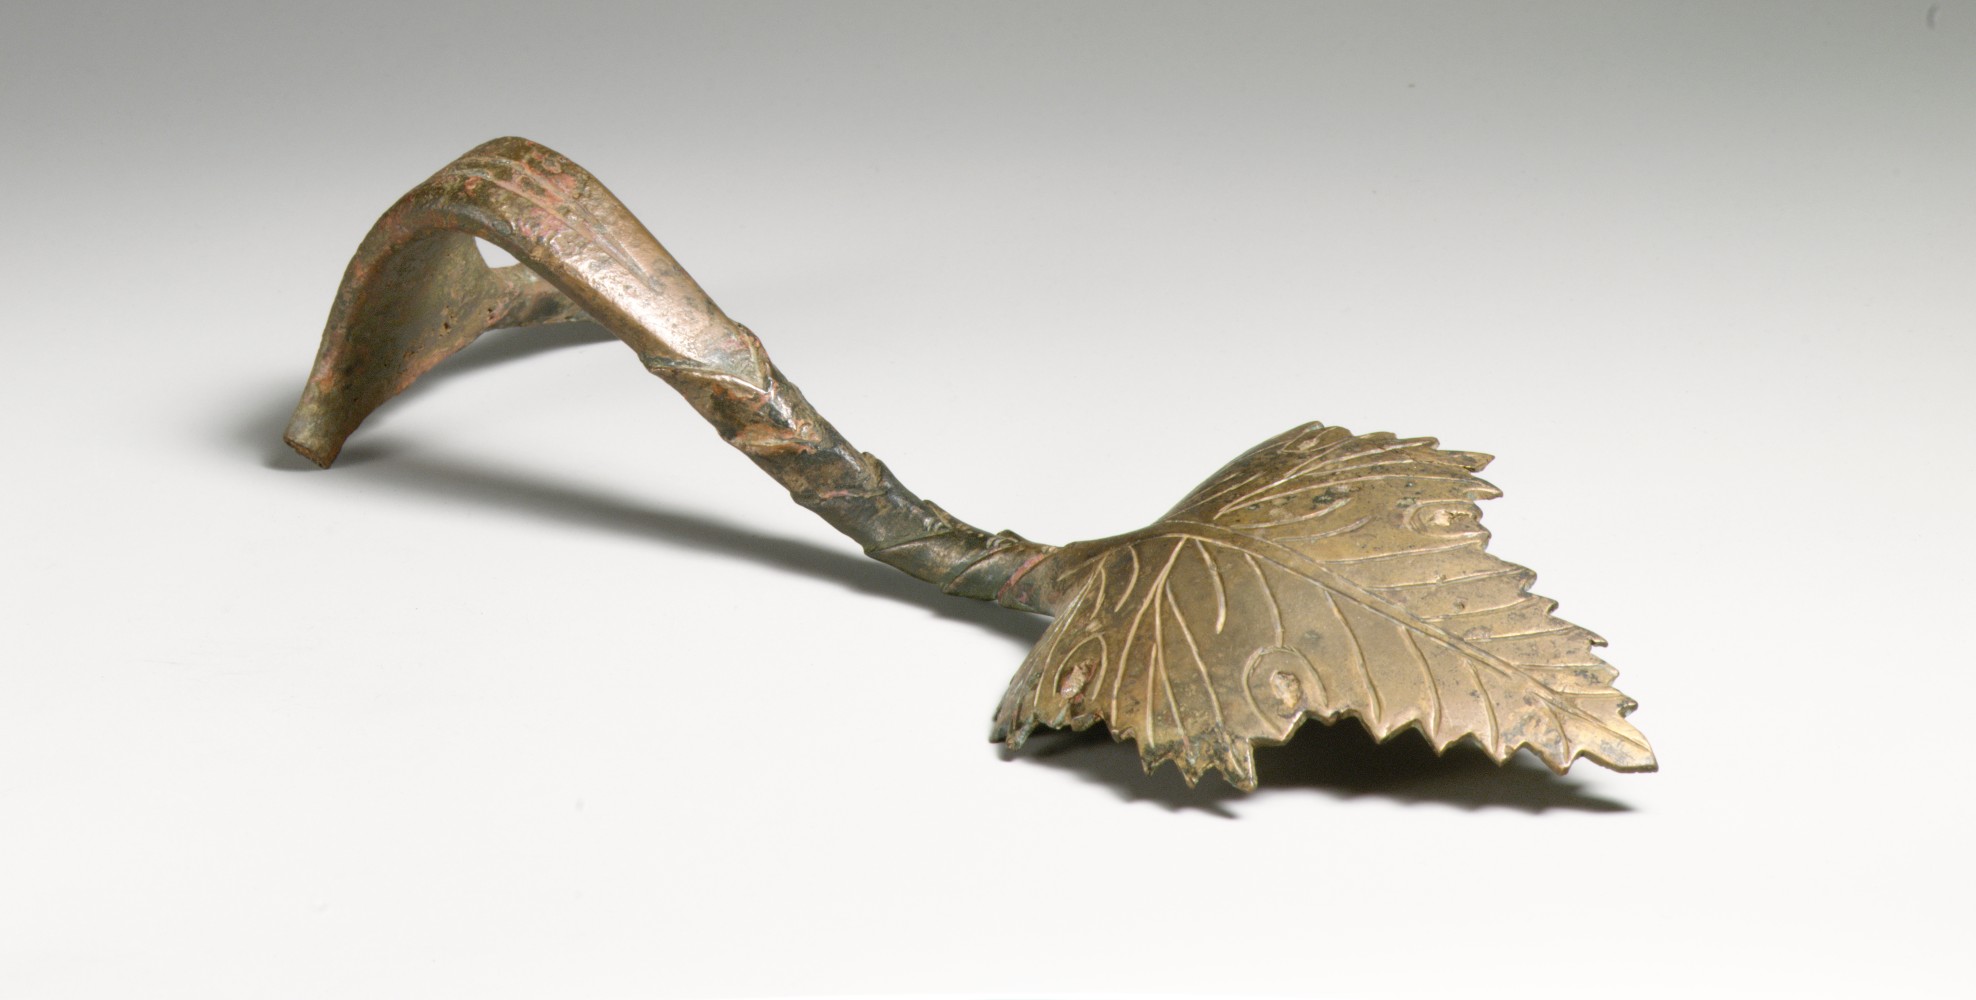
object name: handle of a hydria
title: Bronze handle from a hydria (water jar)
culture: greek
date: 150-101 BCE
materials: bronze